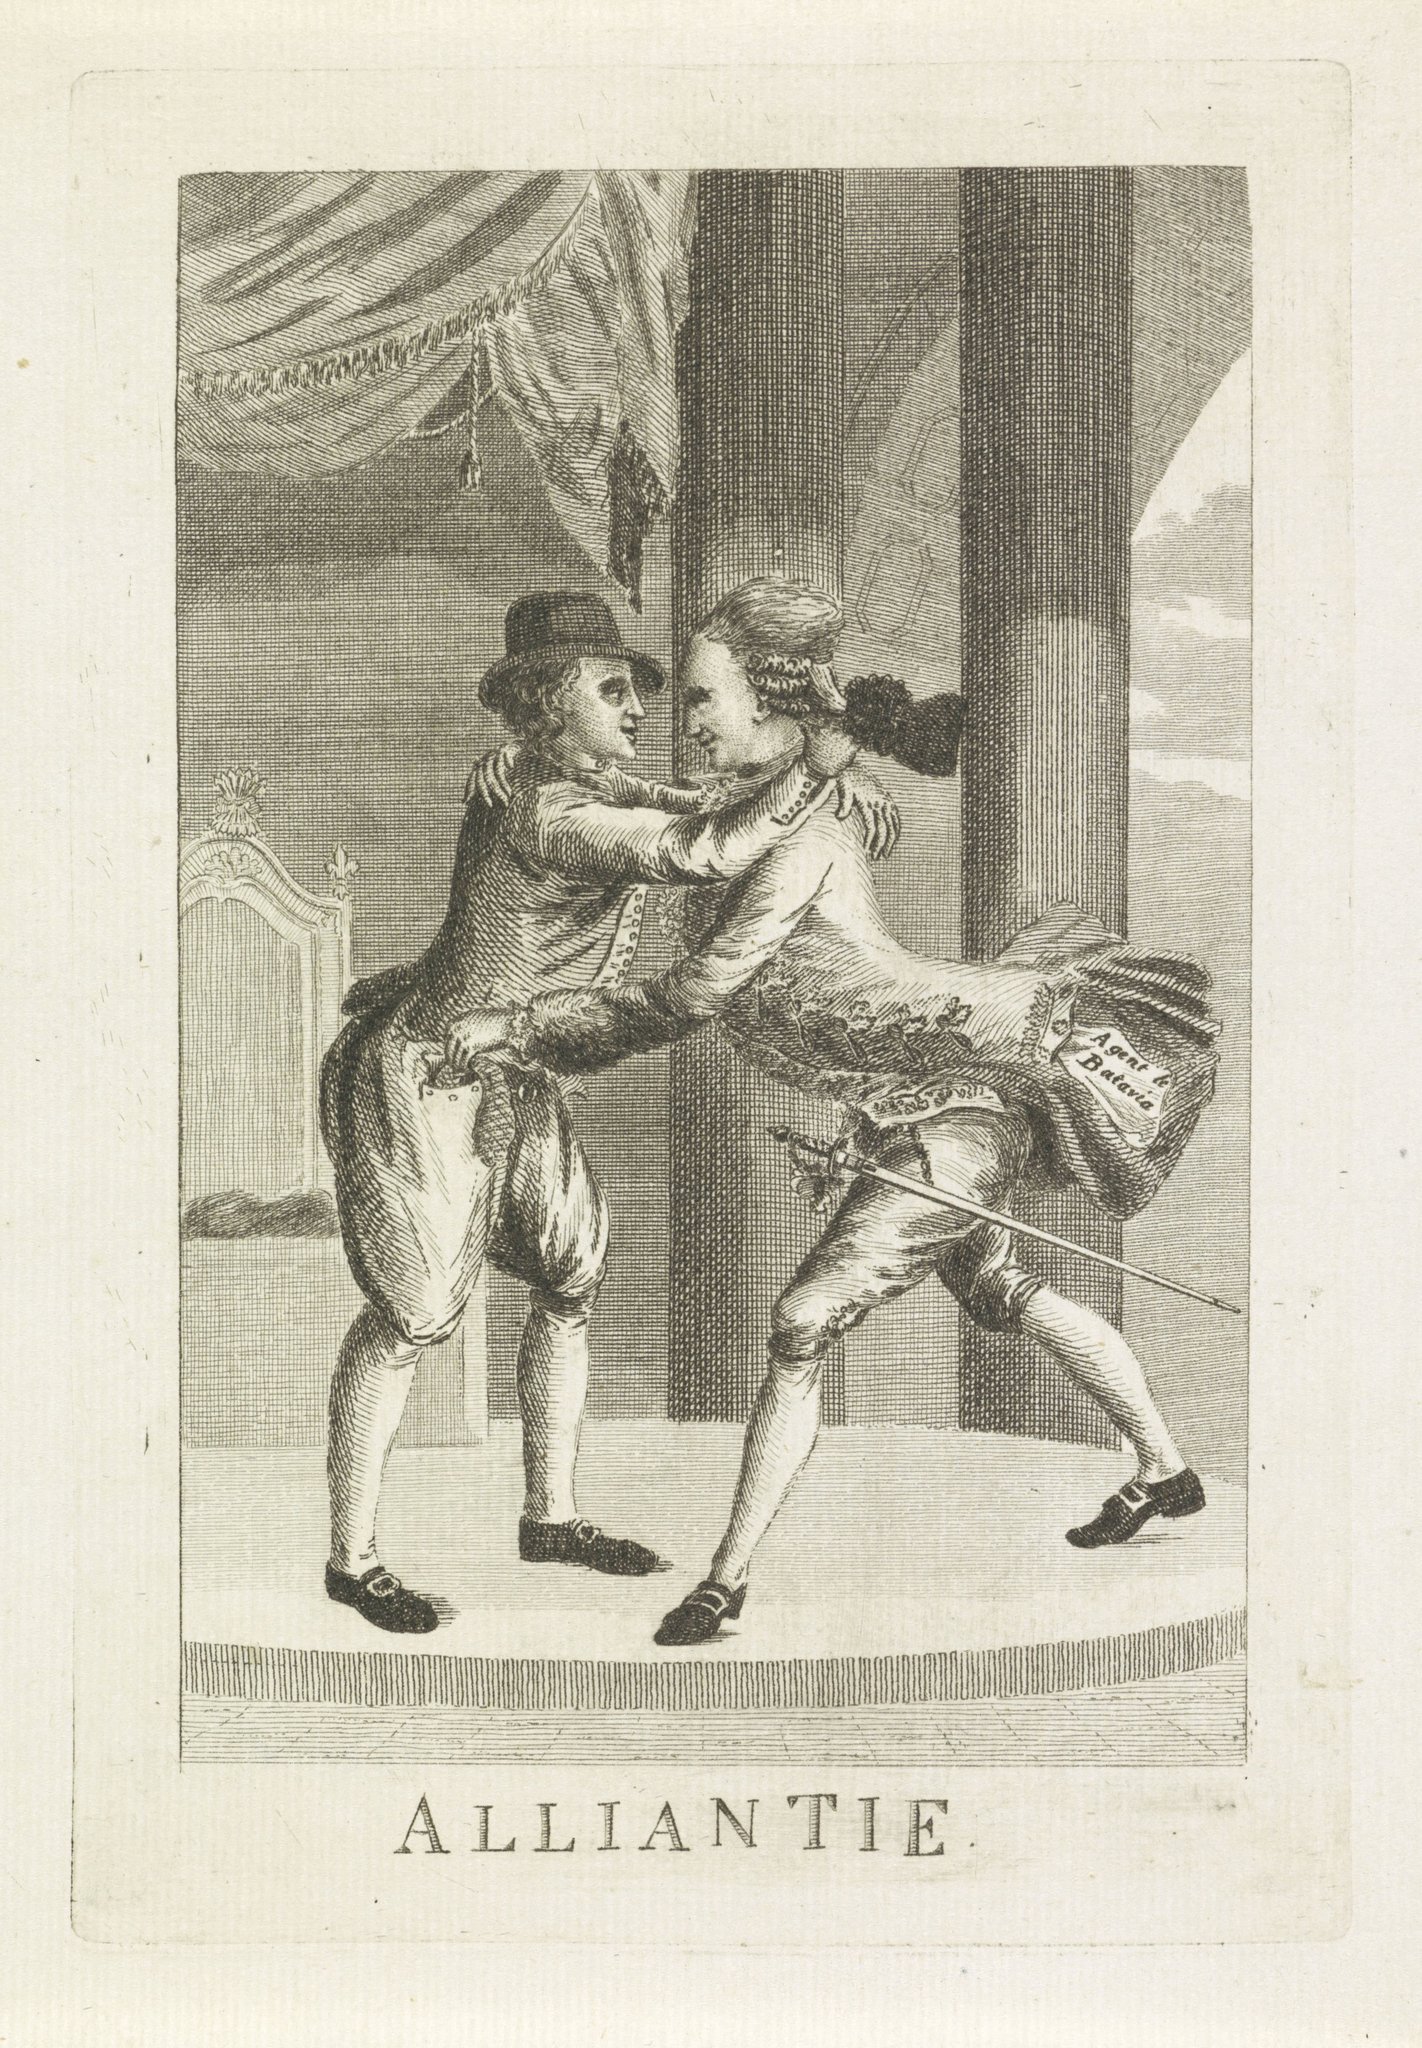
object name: print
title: Spotprent op de Franse broederschap, 1785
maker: Anonymous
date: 1785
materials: paper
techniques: engraving, etching, letterpress printing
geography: netherlands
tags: brotherly love, pickpocket, alliance with france (1785)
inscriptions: collector's mark: Lugt 2228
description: Spotprent op de Franse broederschap, 1785. Een Fransman en Hollander omarmen elkaar terwijl de Fransman de beurs van de Hollander steelt. Waarschijnlijk naar aanleiding van de eerste Alliantie met de Franse Republiek in 1785.